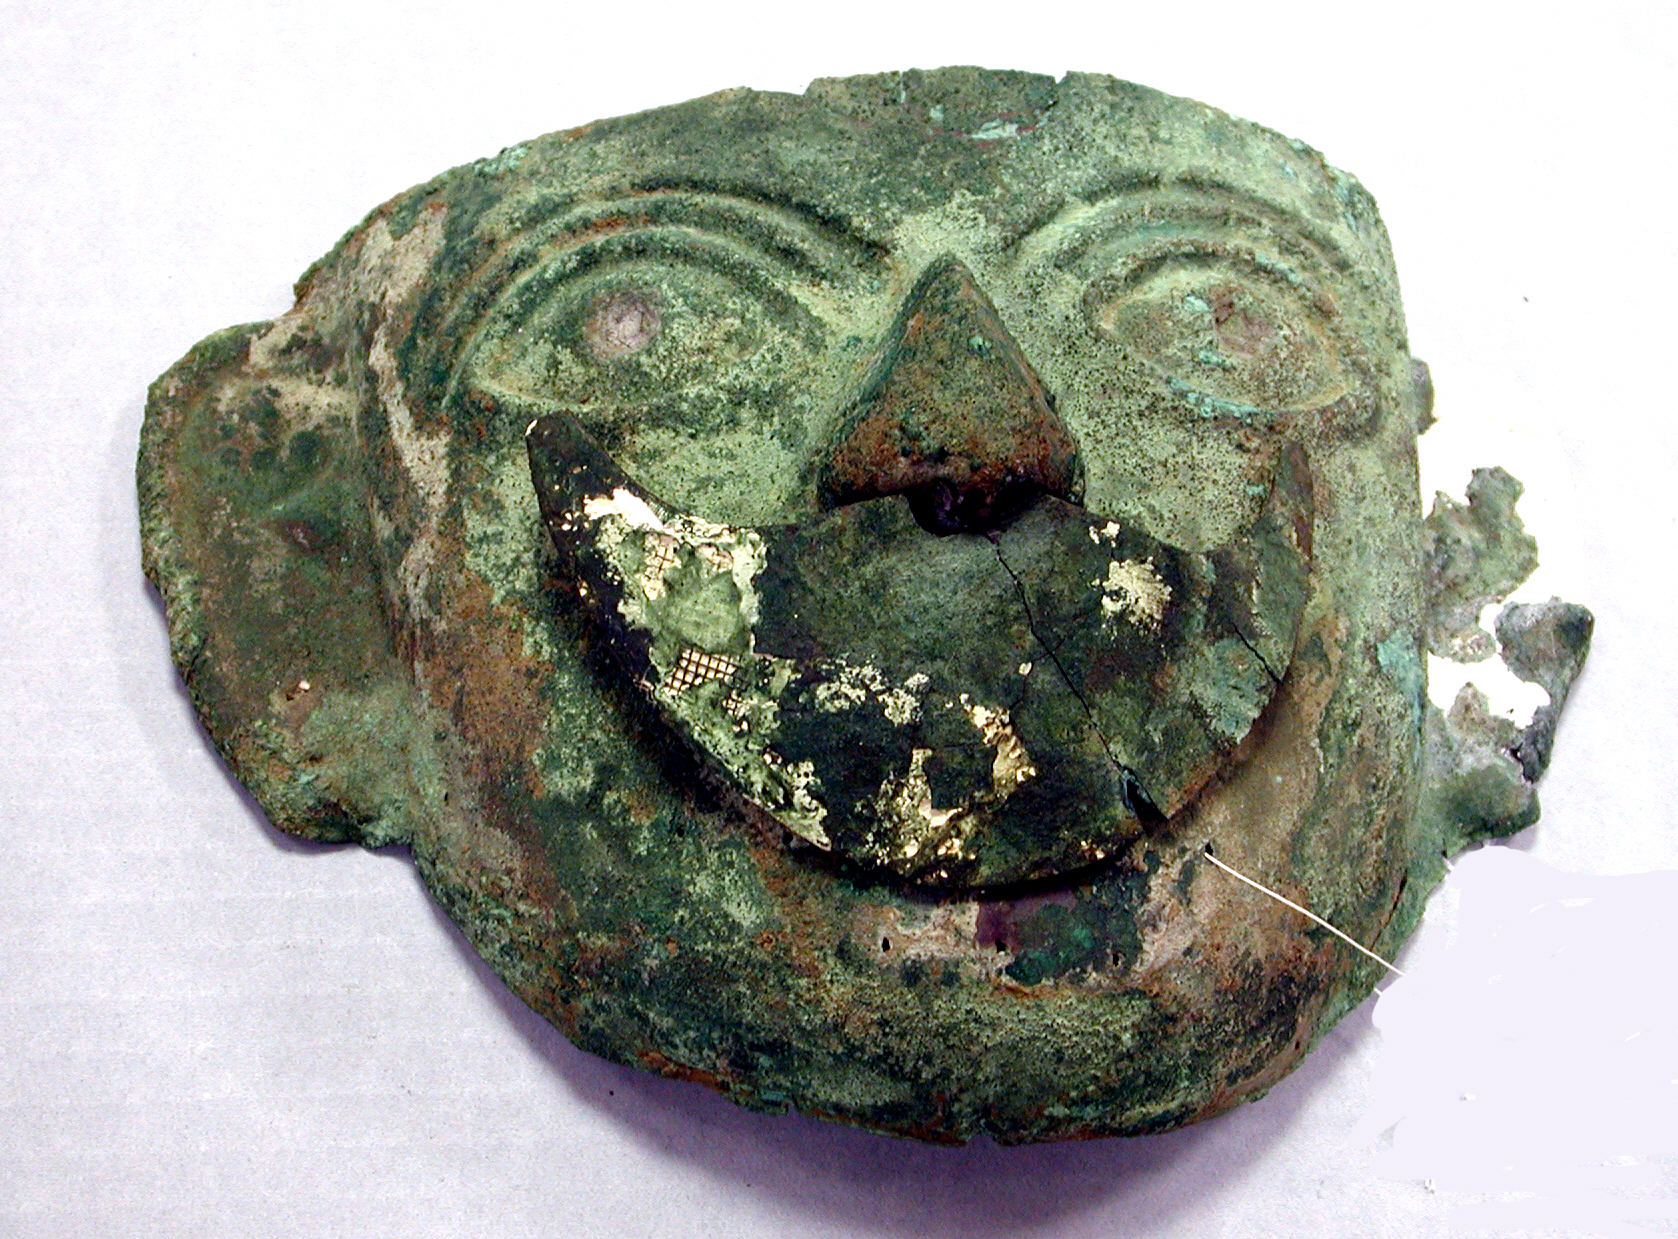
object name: mask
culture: moche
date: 101-700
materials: copper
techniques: hammering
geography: peru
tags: faces